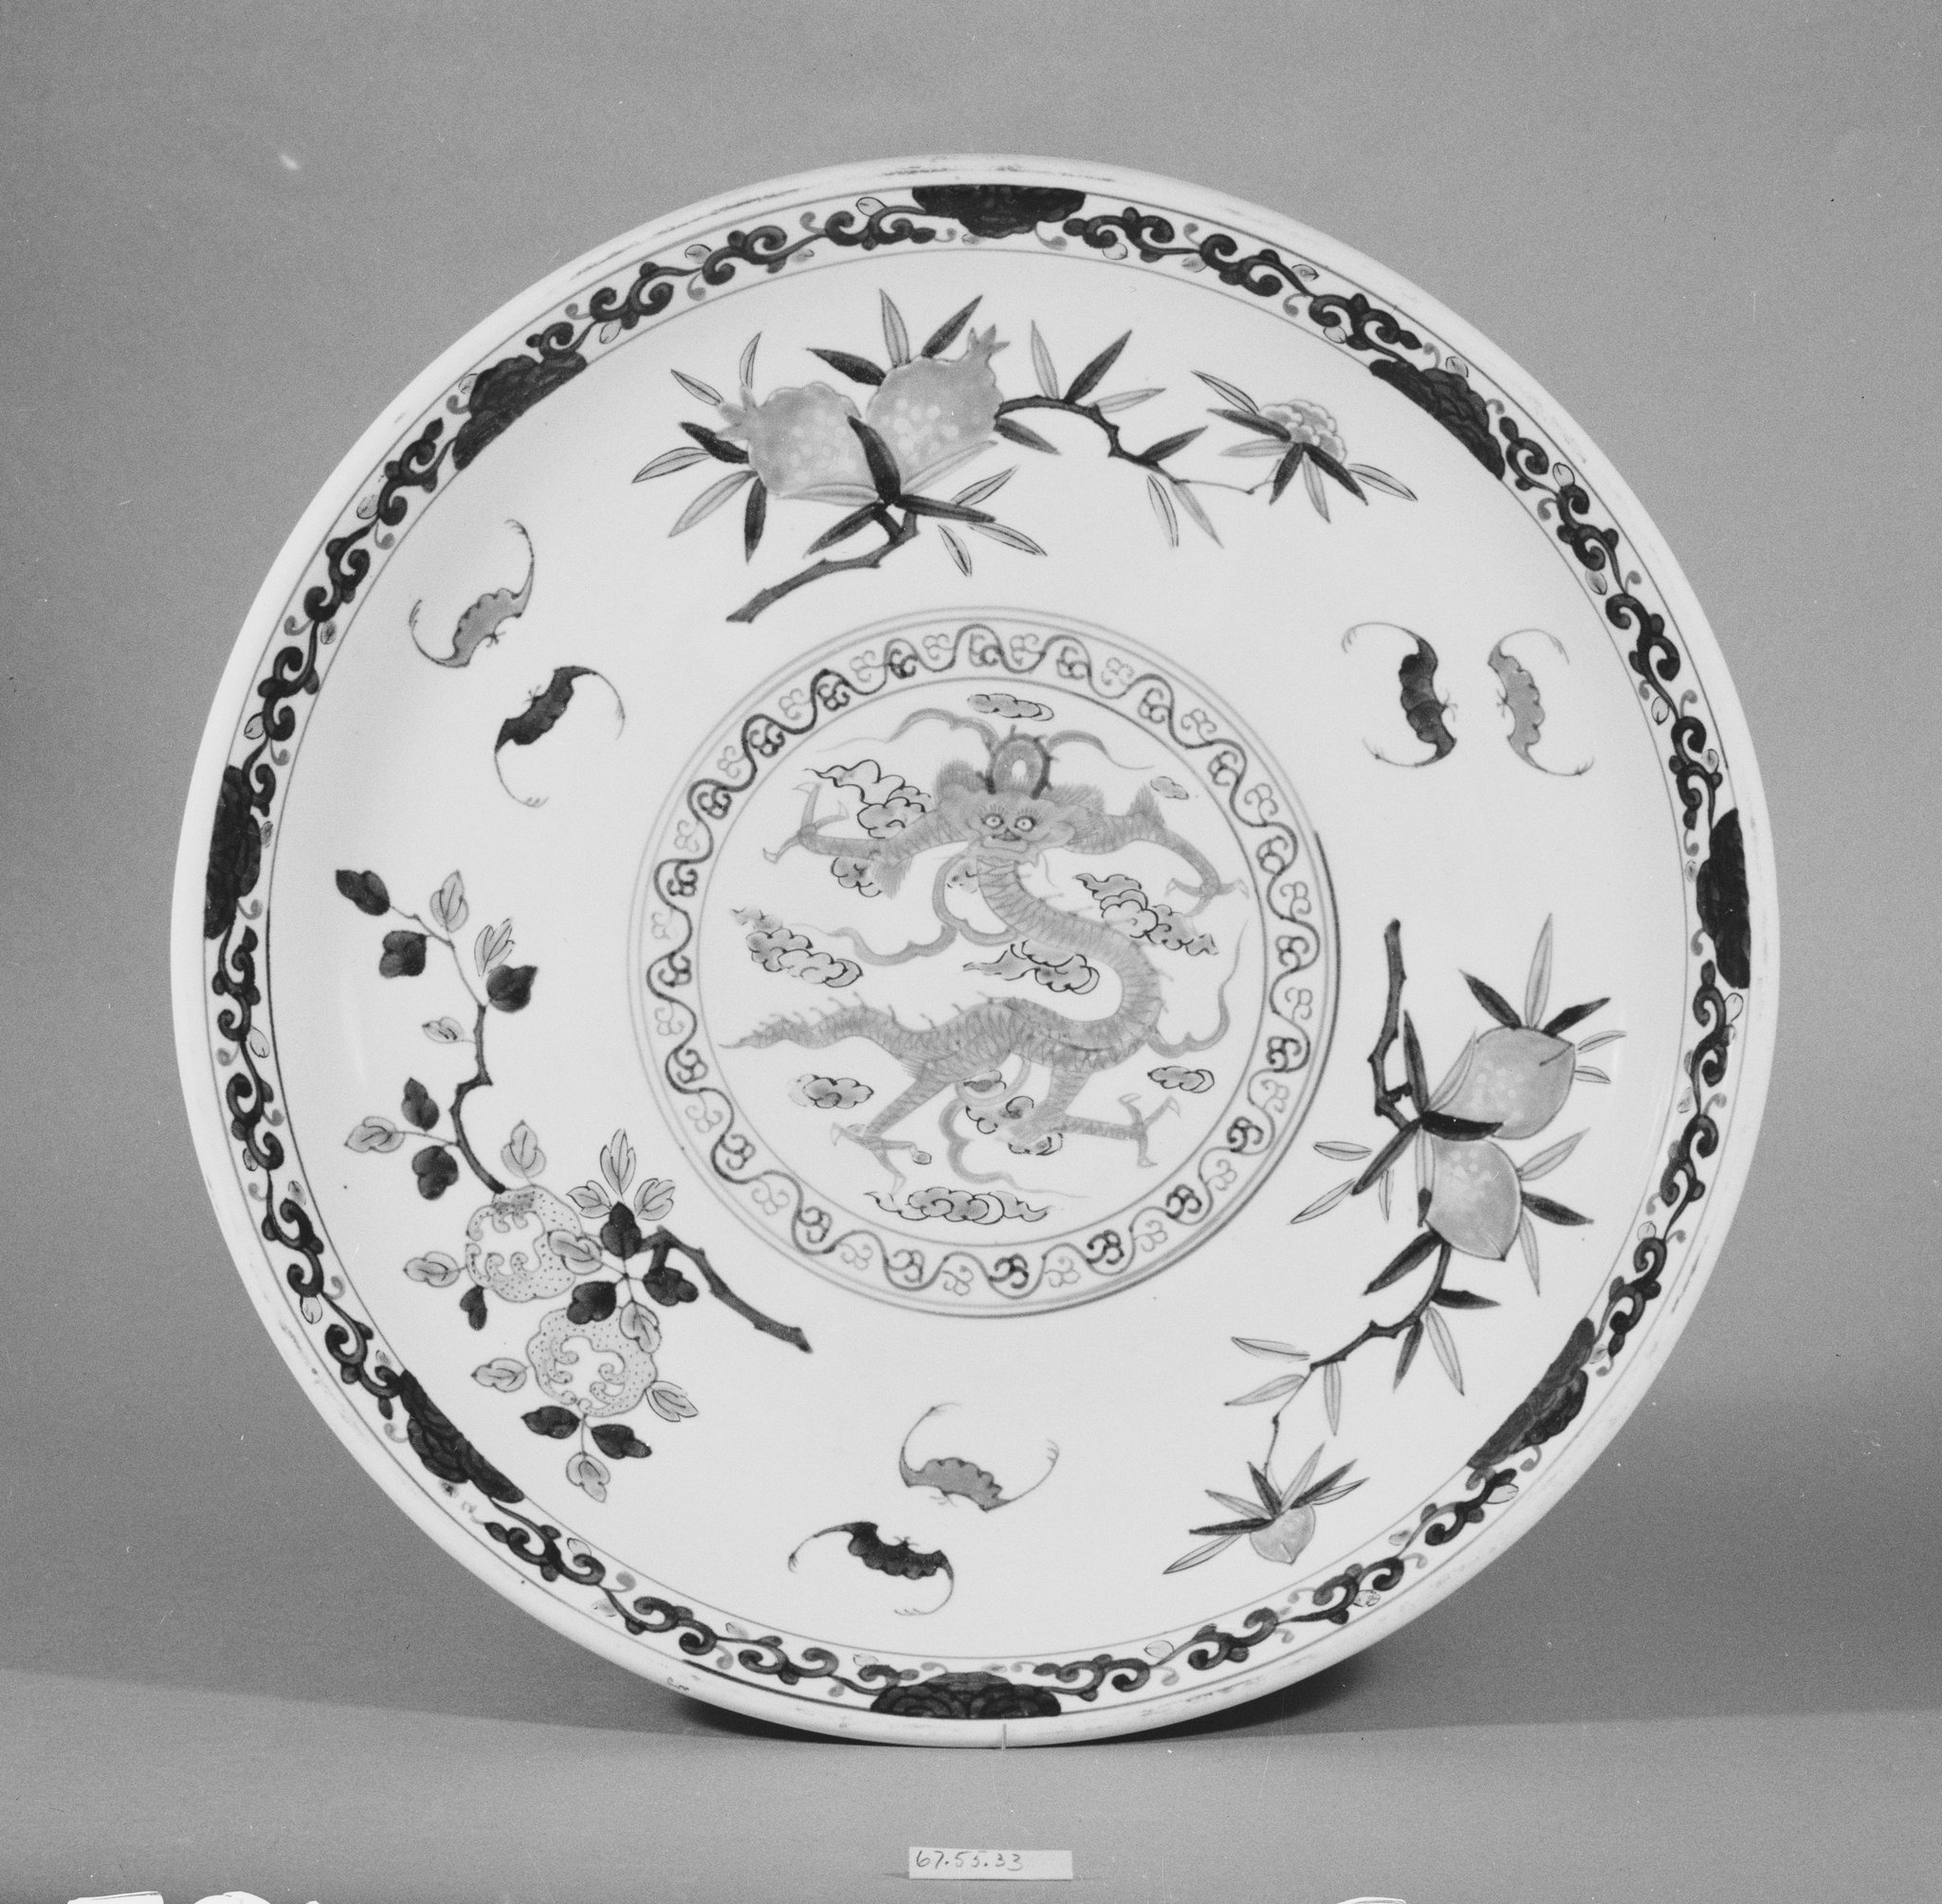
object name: plate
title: Plate (one of a pair)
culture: japanese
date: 1701-1800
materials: enamel, porcelain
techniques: underglaze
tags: dragons